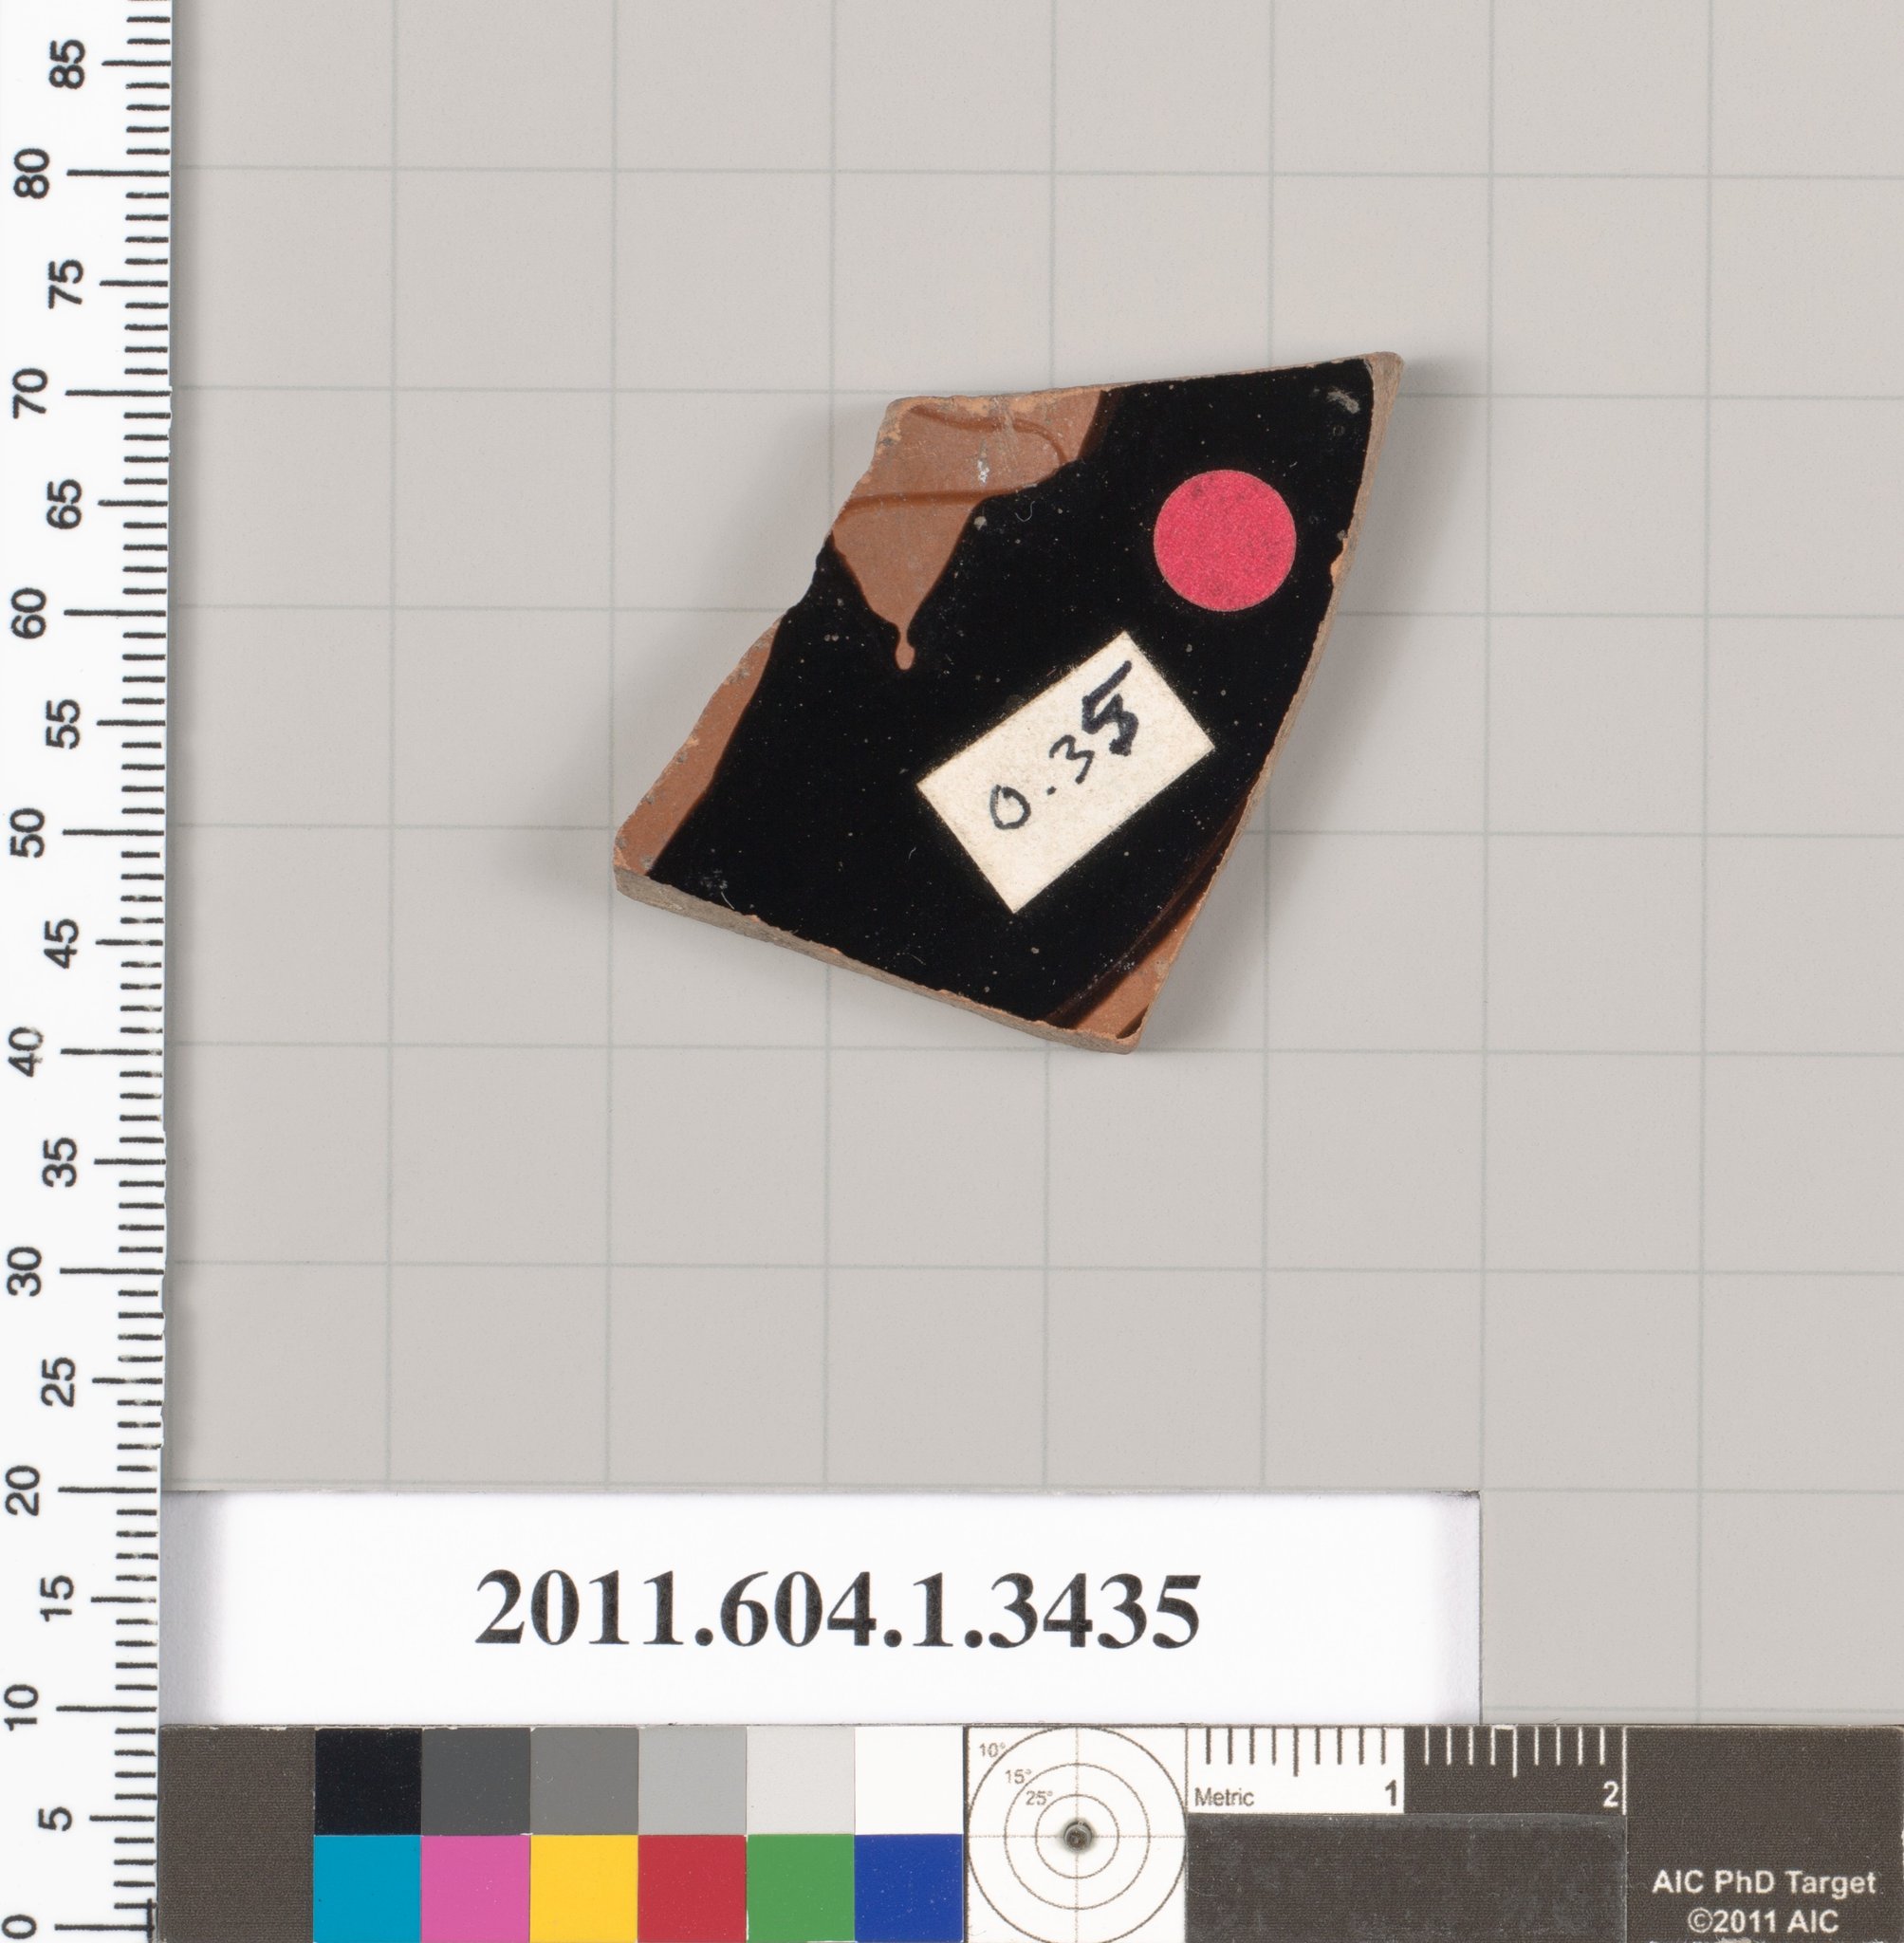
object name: kylix fragment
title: Terracotta fragment of a kylix (drinking cup)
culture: greek, attic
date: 500-470 BCE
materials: terracotta